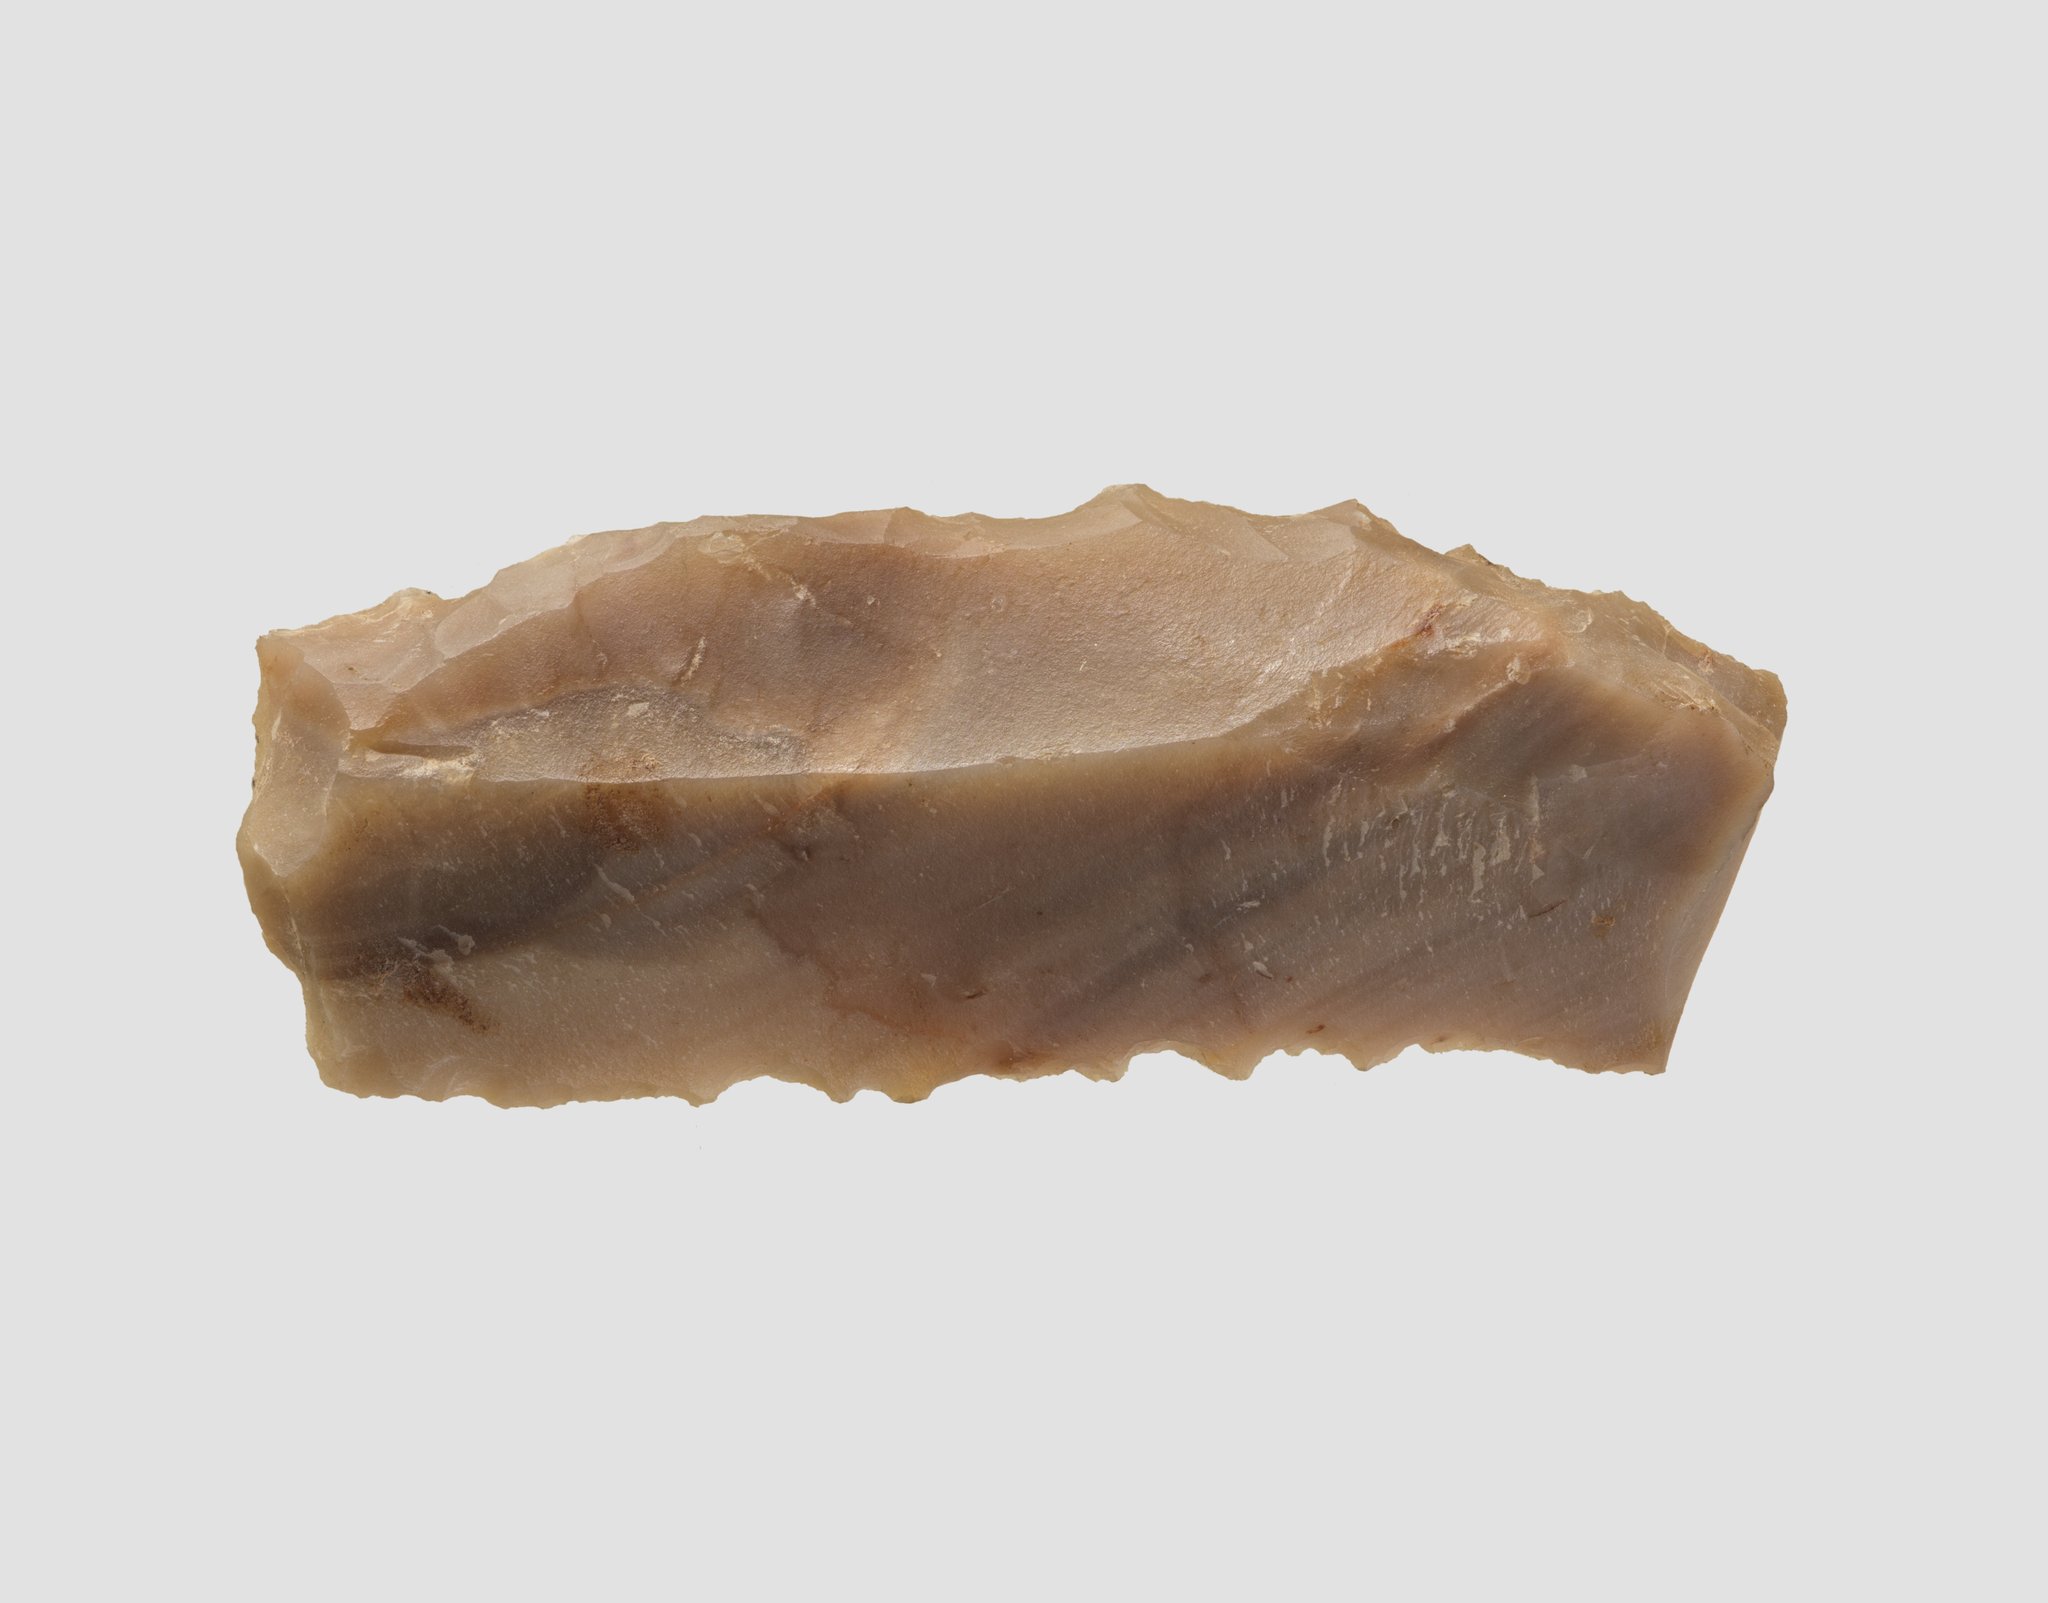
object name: knife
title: Blade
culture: ghassulian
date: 4600-3600 BCE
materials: stone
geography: levant